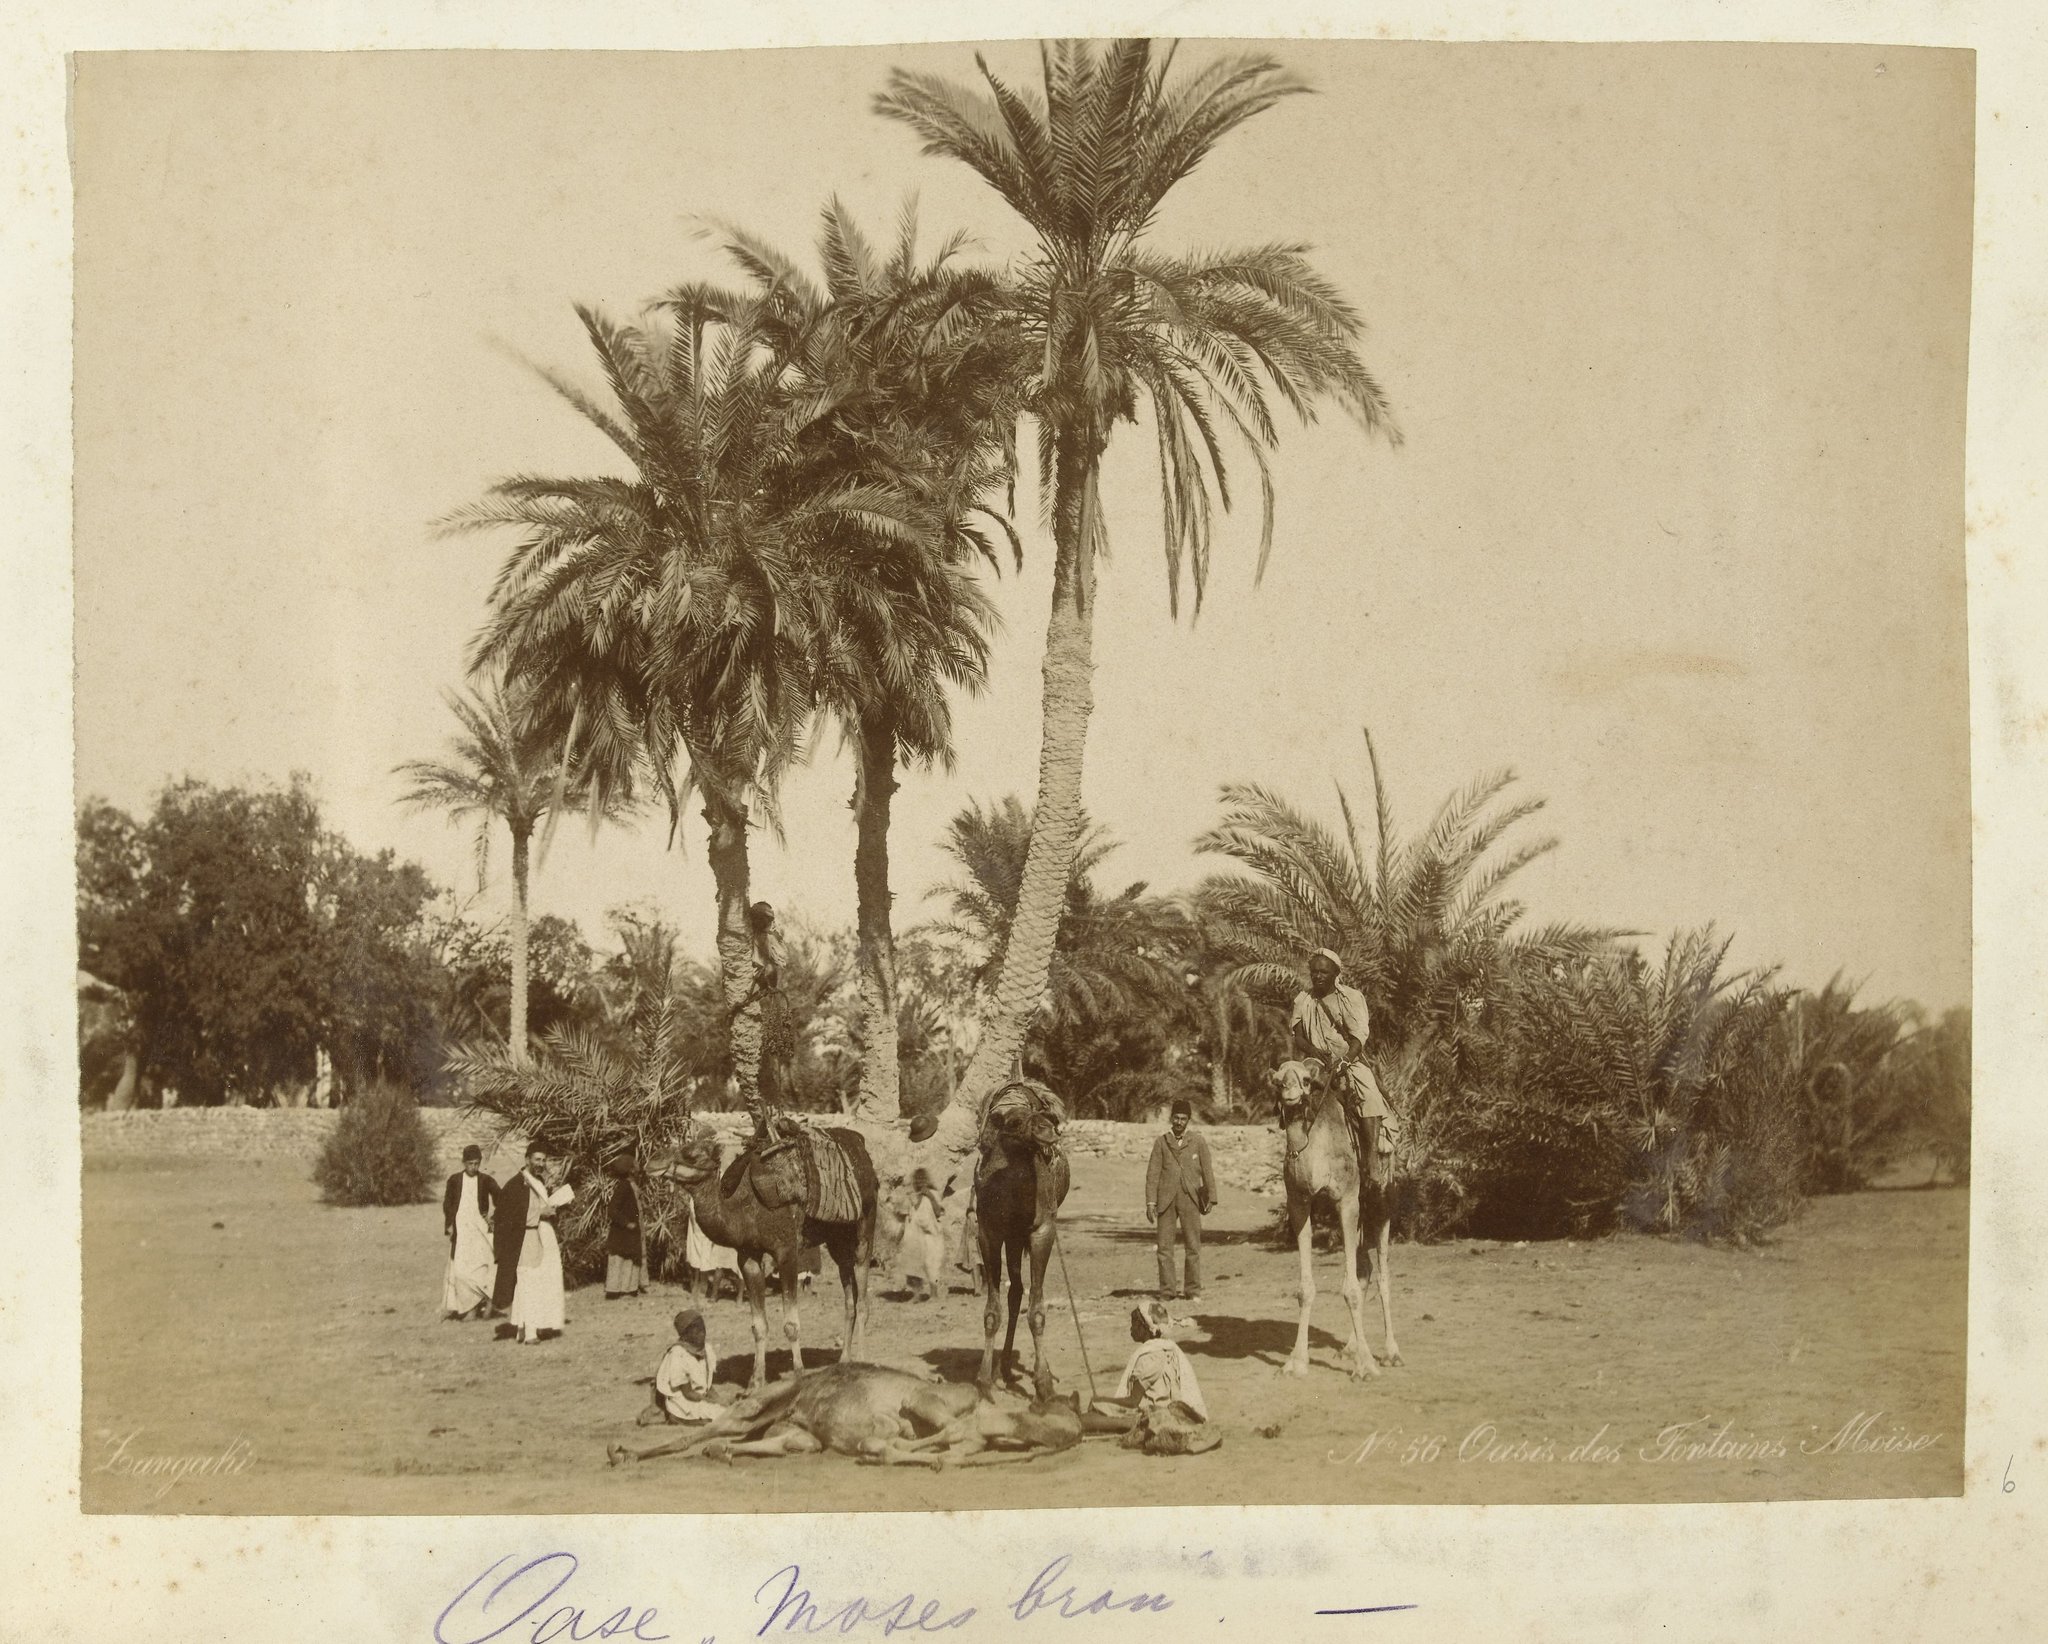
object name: photograph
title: Oase "Mozes bron".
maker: Anonymous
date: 1890-1910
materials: cardboard, paper, photographic support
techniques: gelatin silver print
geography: netherlands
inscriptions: title: ‘No 56. Oasis des Fontains Moise’, caption: ‘Karavaan’